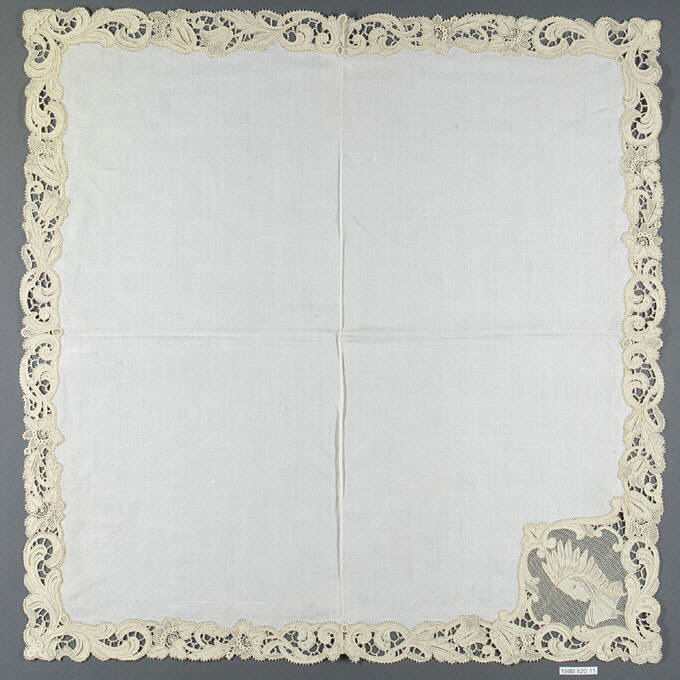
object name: napkin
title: Napkin (from a set of table linens)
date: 1867-1900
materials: linen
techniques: lace